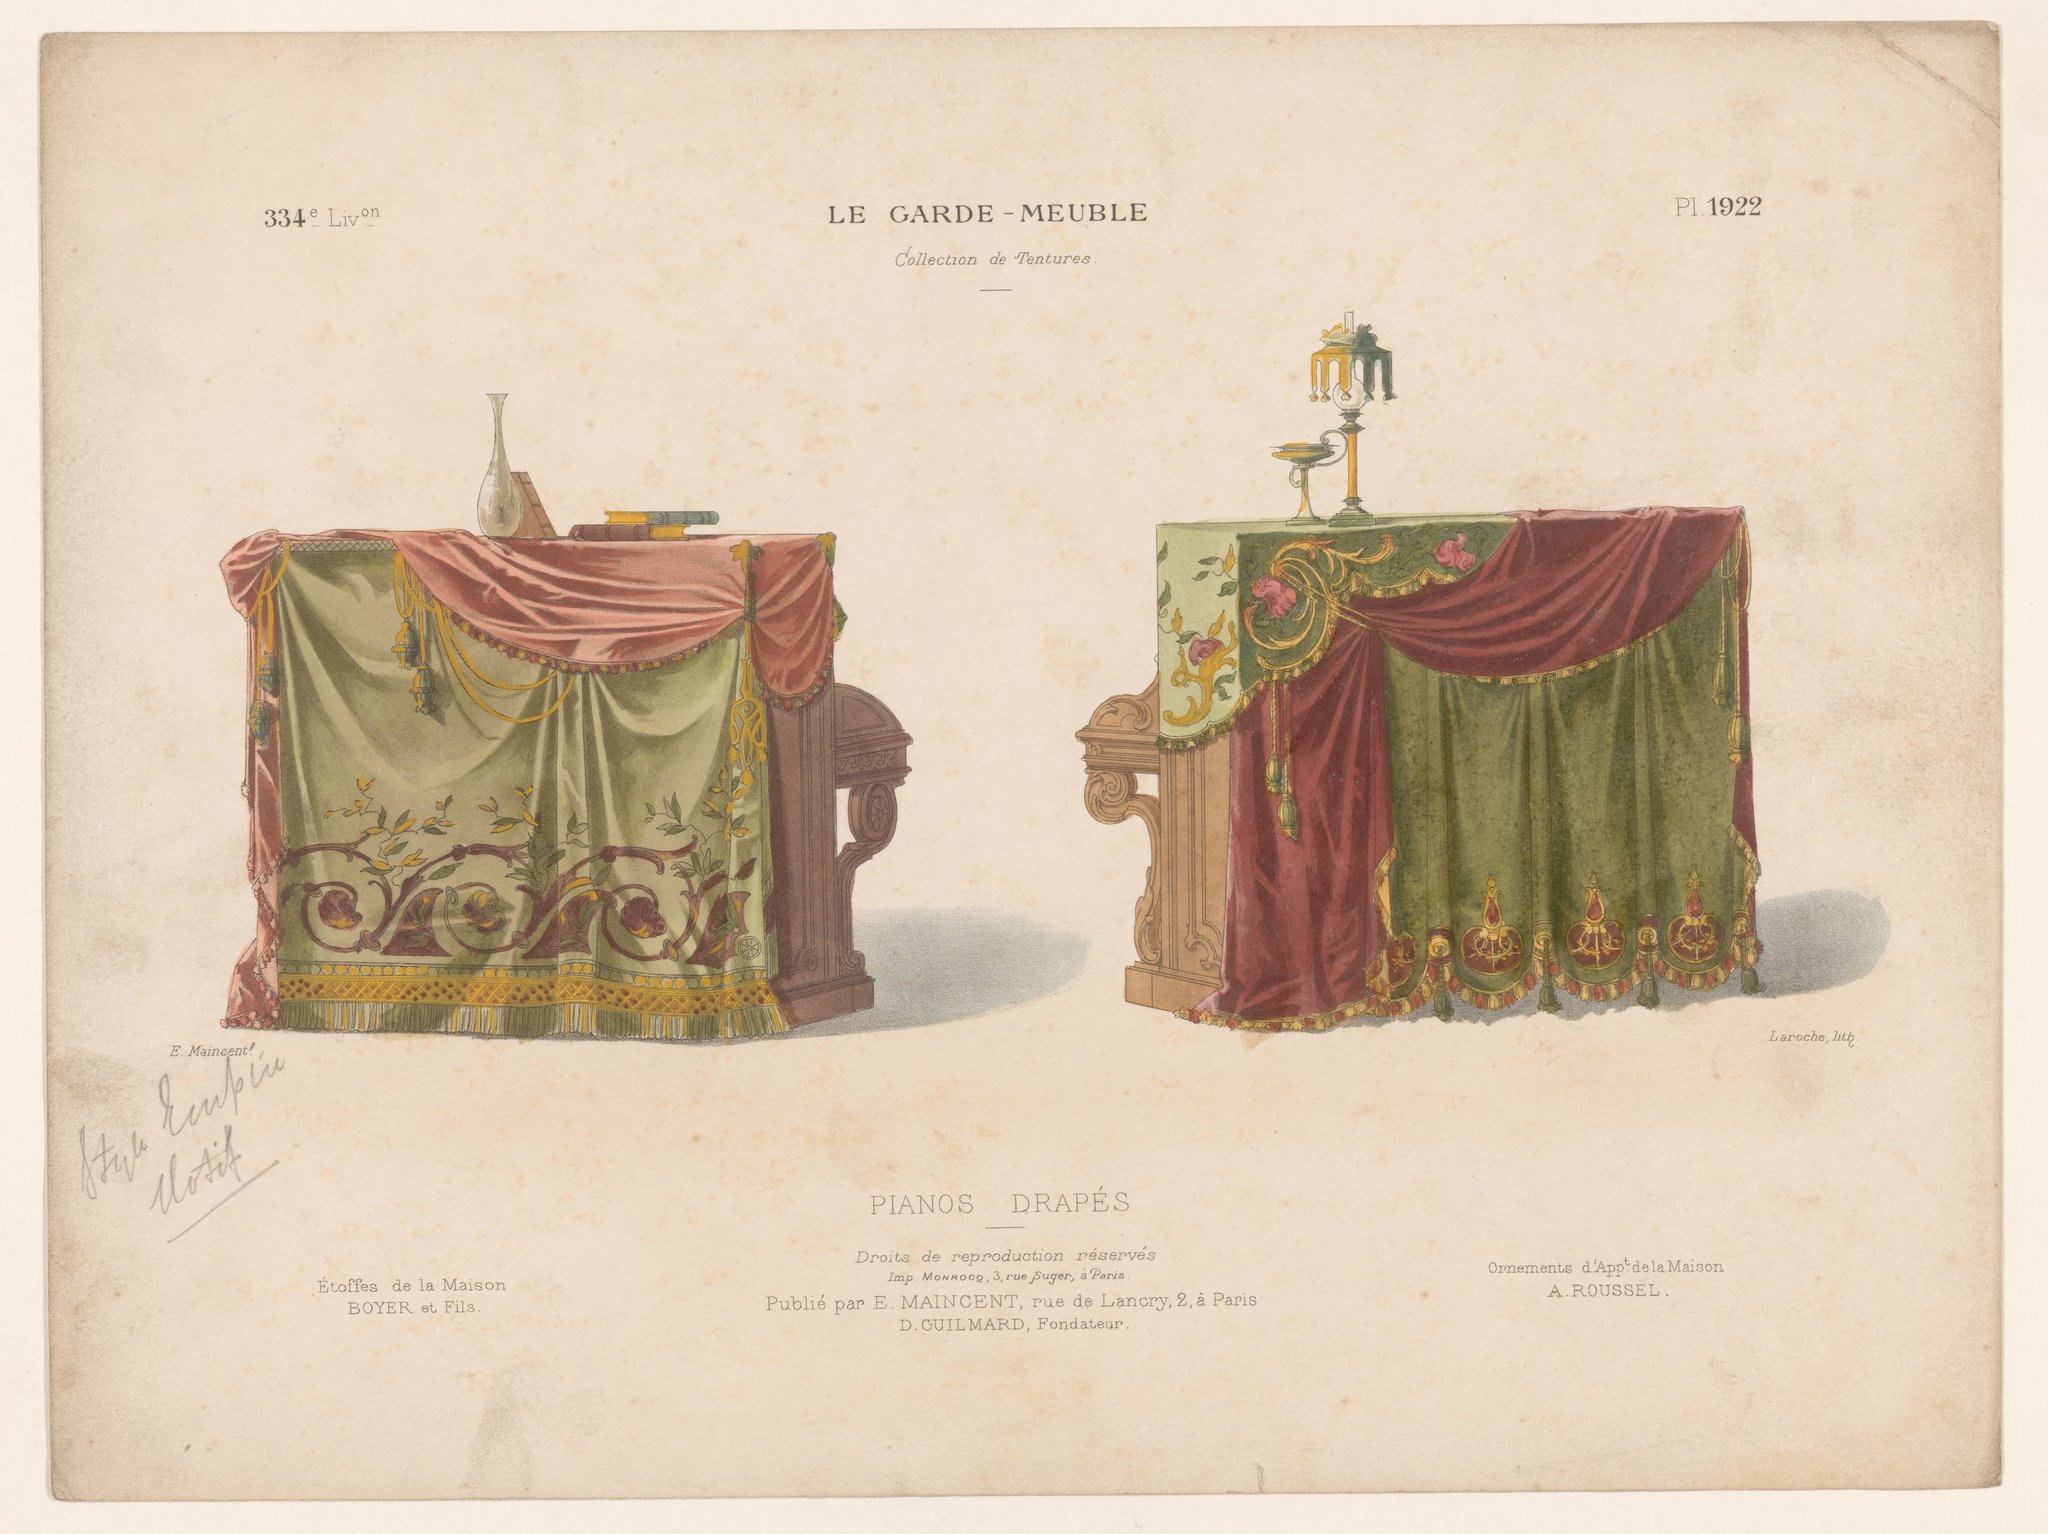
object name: print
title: Piano's met draperieën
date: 1885-1895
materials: paper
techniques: hand coloring, lithograph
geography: paris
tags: hangings and drapery, pianoforte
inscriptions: annotation: ‘Stijl Empire Motief’, : ‘Droits de reproduction réservés.’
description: Twee piano's met draperieën. Prent uit 334e Livraison.